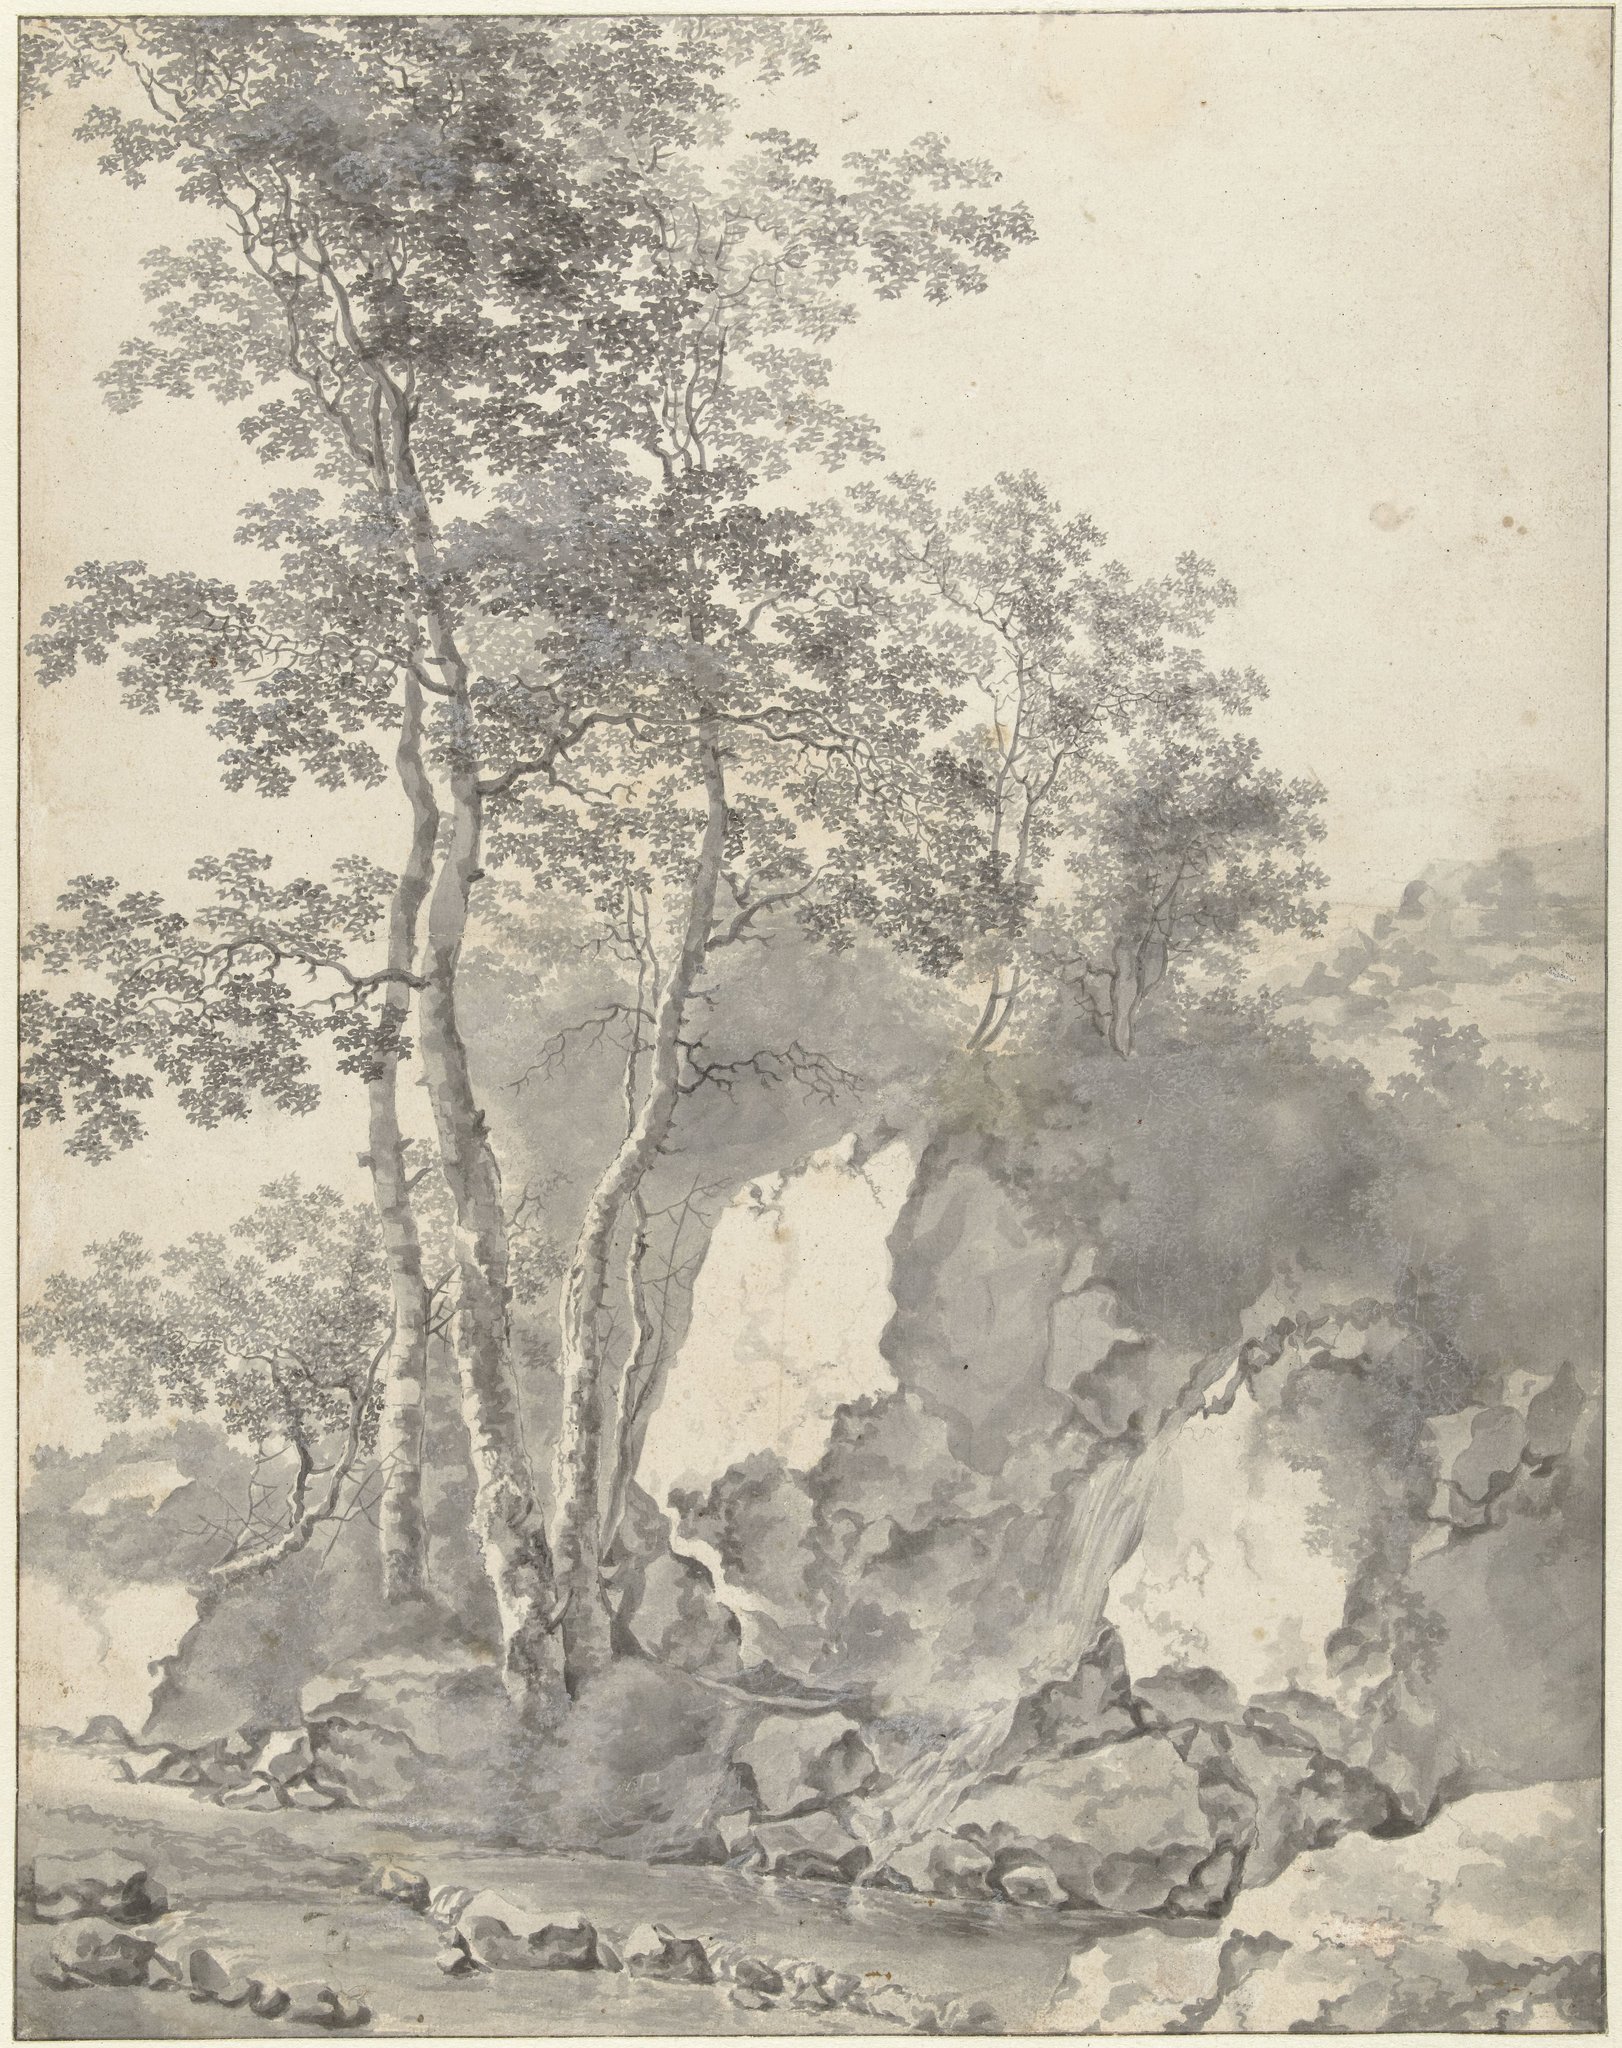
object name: drawing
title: Groep berken bij een bergstroom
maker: jan both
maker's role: draughtsman, painter, print maker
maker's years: 1618-1652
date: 1628-1652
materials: paper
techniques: brush